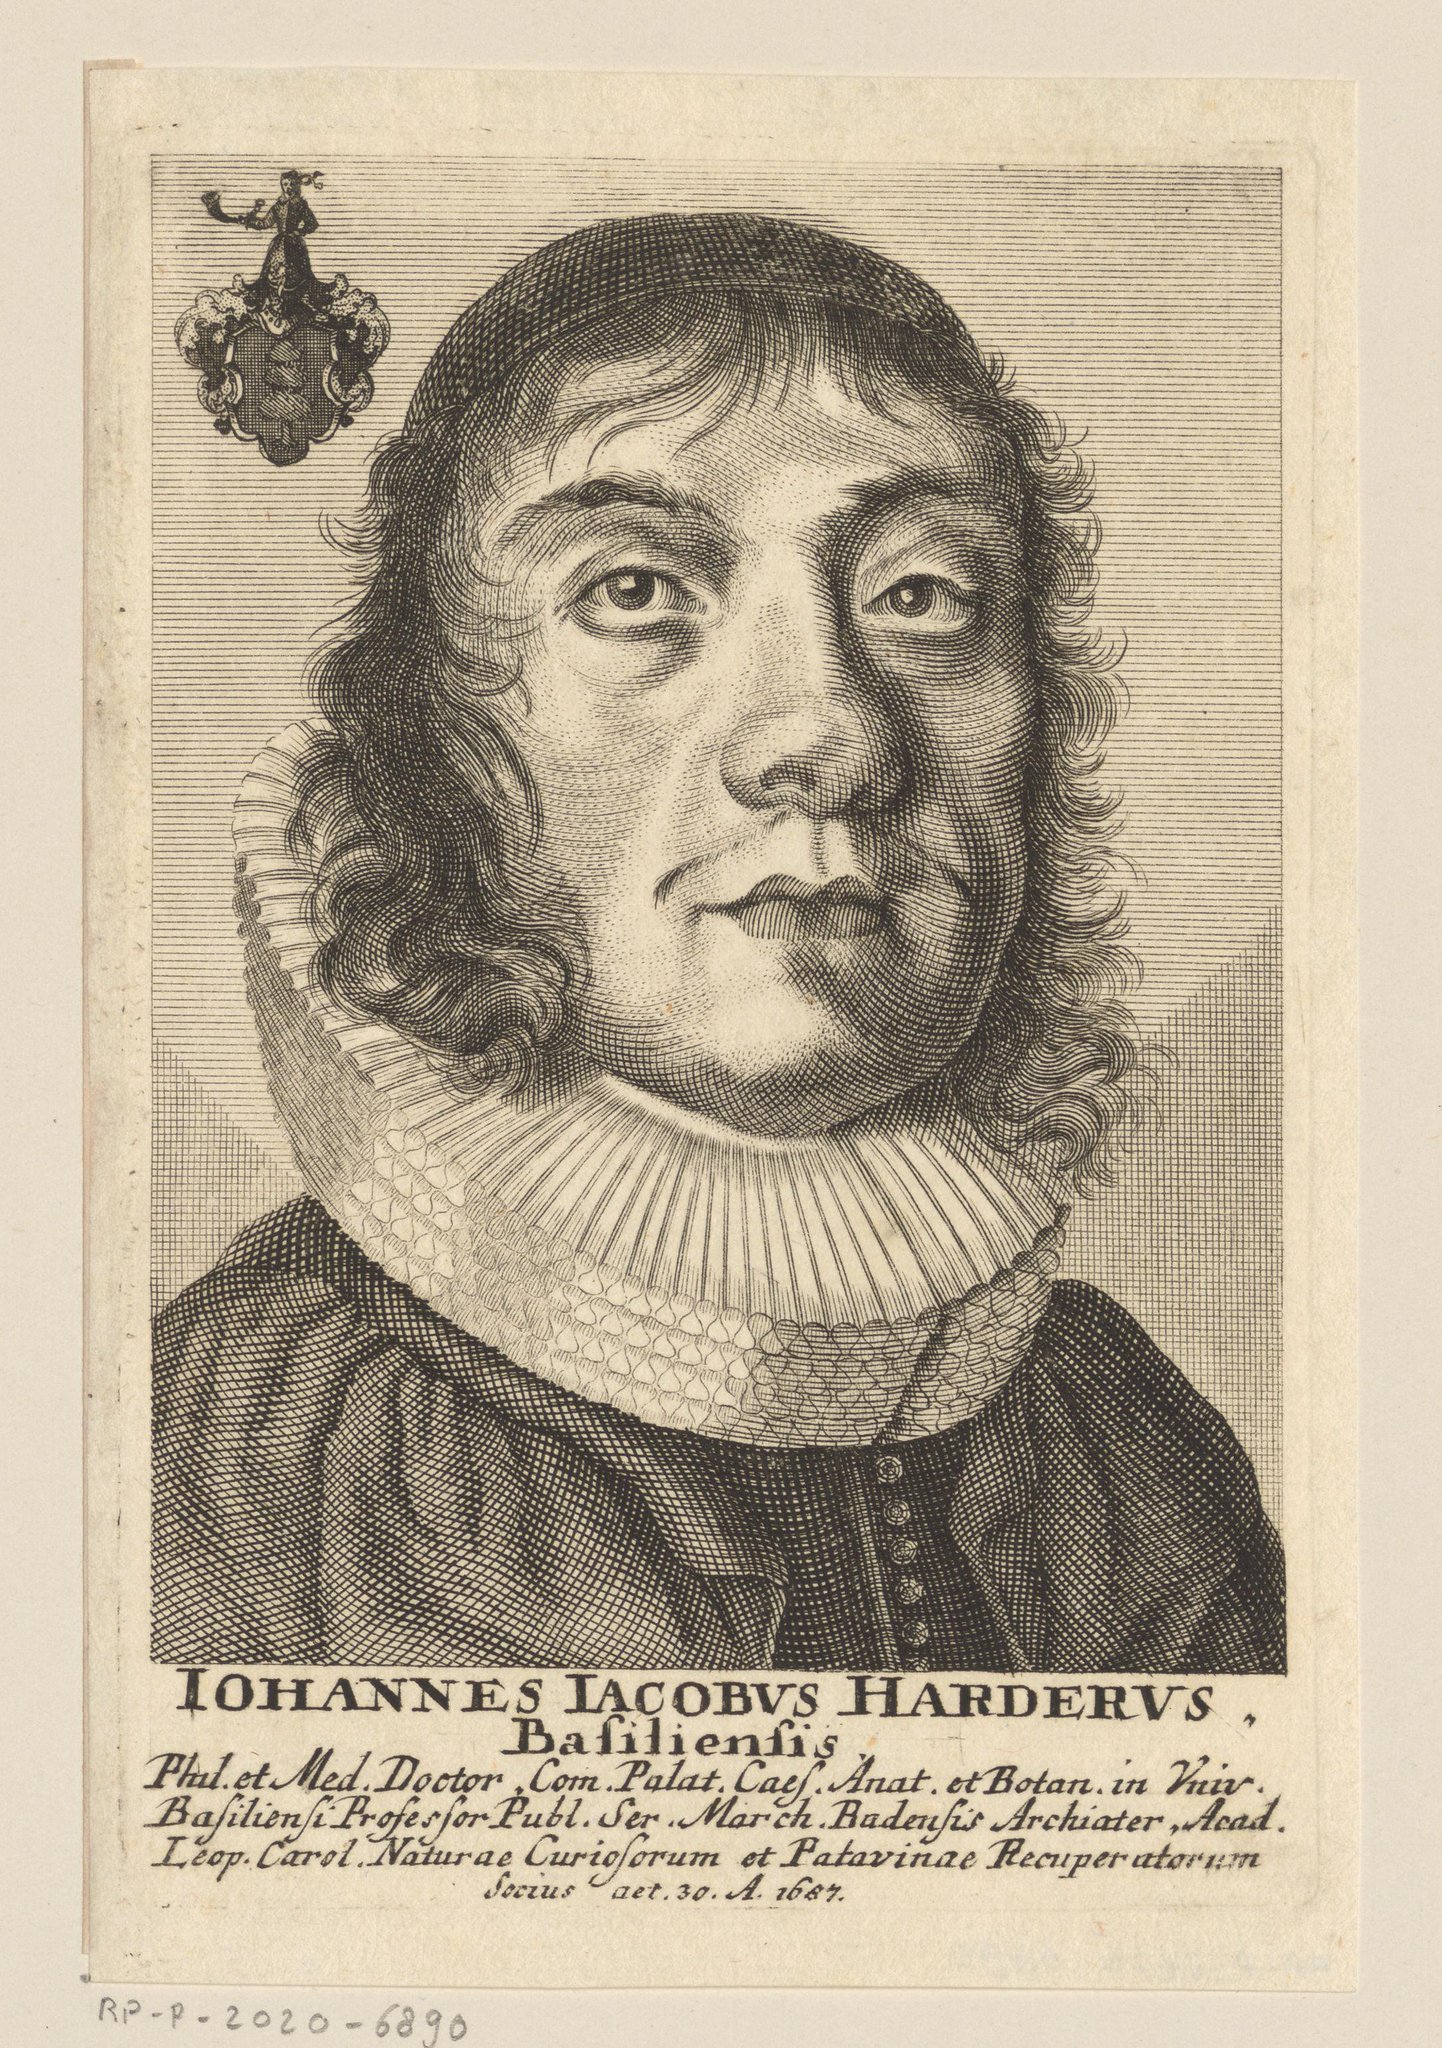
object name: print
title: Portret van Johann Jakob Harder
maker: Anonymous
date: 1700-1749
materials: paper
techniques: engraving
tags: historical persons, physician, doctor, armorial bearing, heraldry